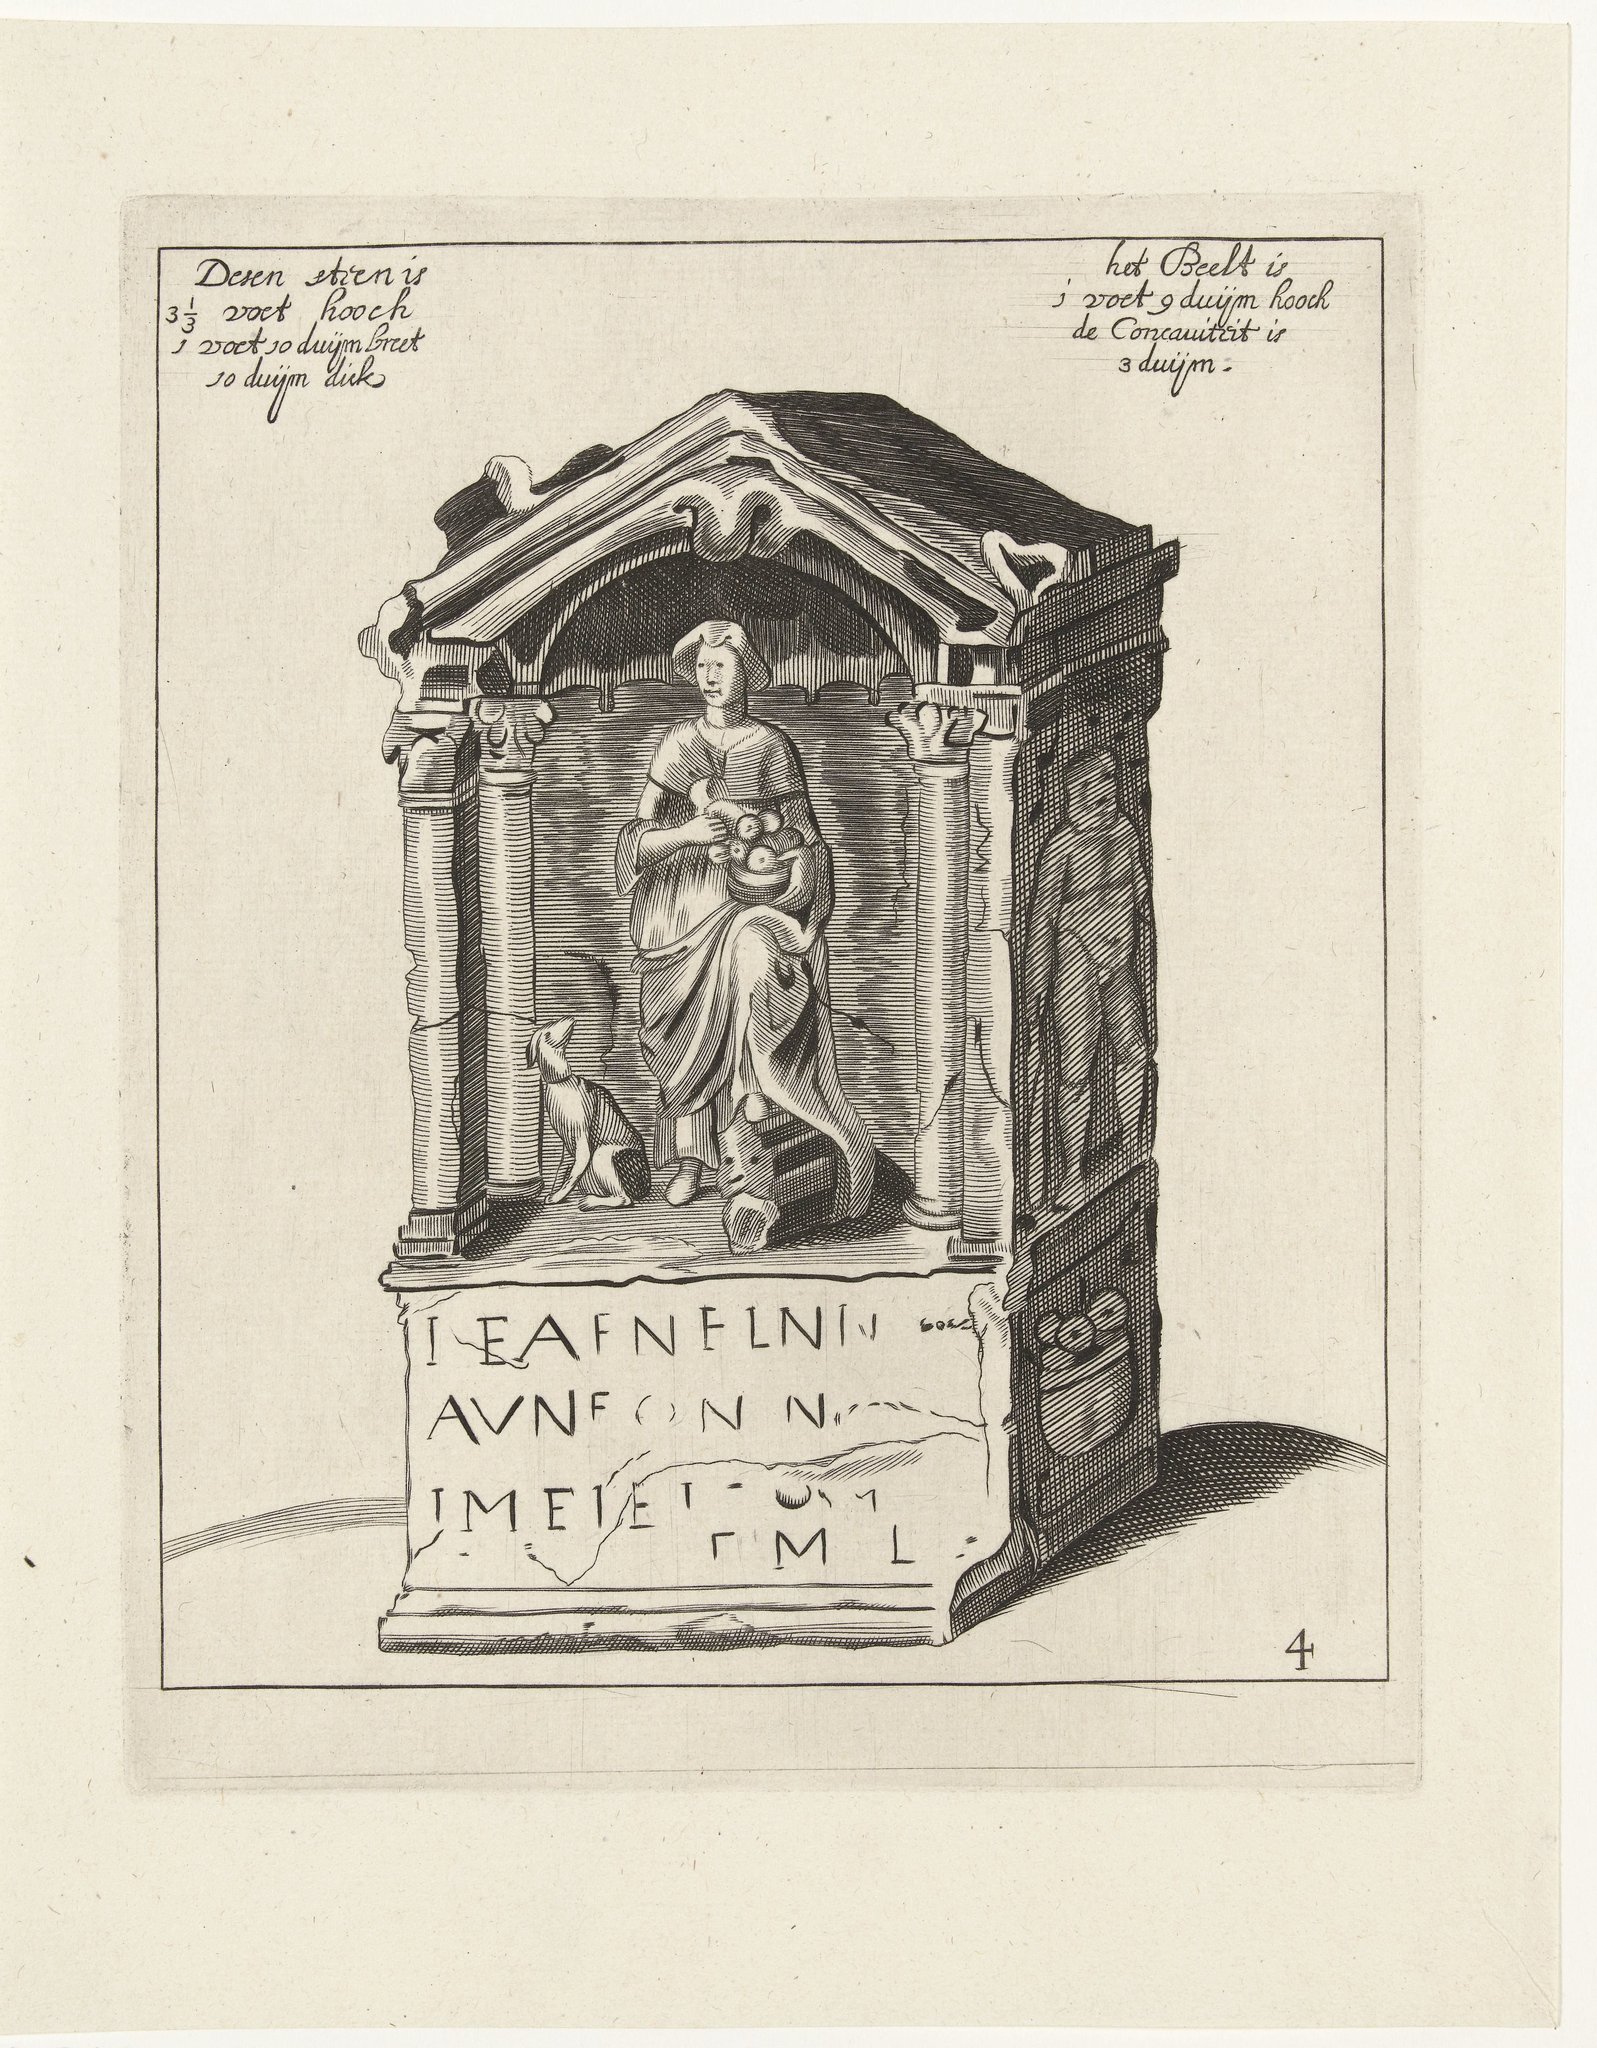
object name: historical object representation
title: Oudheden gevonden op het strand van Walcheren in 1647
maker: hendrick danckerts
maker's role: print maker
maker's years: 1625-1679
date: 1647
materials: paper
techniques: engraving, etching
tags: other foreign deities included in the classical pantheon (with name)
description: Altaar van de Romeinse godin Nehalennia.